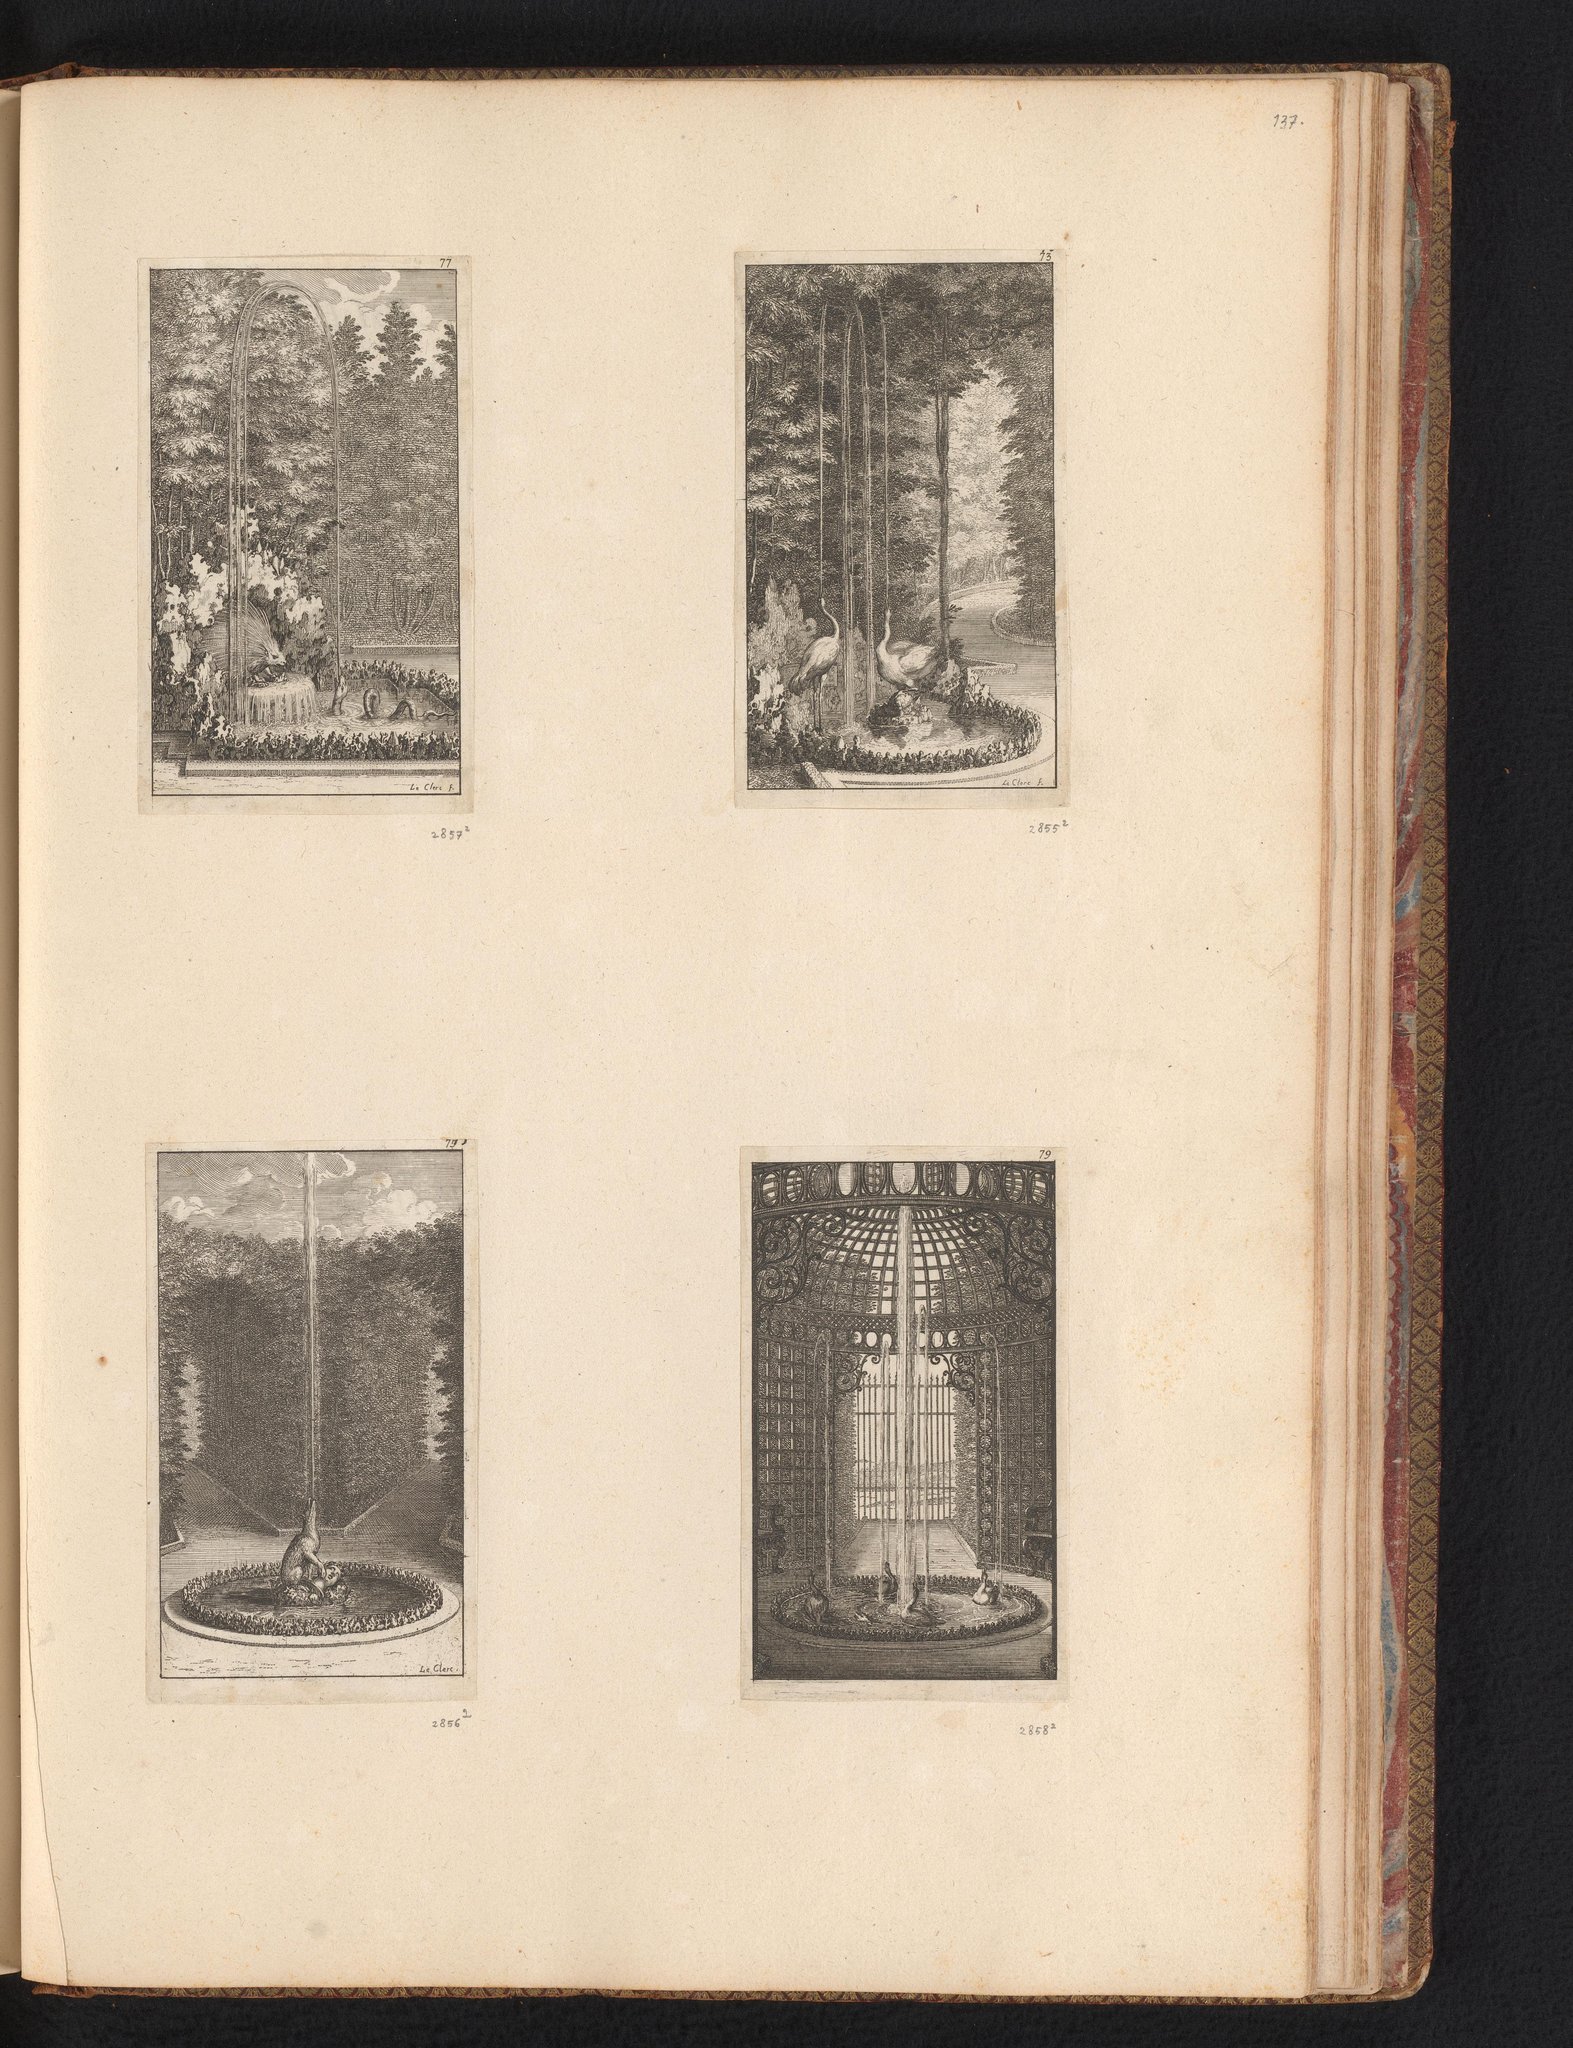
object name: print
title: Vier gezichten op het labyrint van het Paleis van Versailles met fonteinen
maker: sébastien leclerc (i)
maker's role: print maker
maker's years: 1637-1714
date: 1677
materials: paper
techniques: etching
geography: paris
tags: garden fountain, fables of aesop : use 85(...), labyrinth, maze ~ garden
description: Prenten uit: Perrault, Charles. Labyrinthe de Versailles. Parijs: Imprimerie Royale, 1677. Hierin staan veertig prenten van het labyrint in de tuin van het Paleis van Versailles met verschillende fonteinen gebaseerd op de fabels van Aesopus.